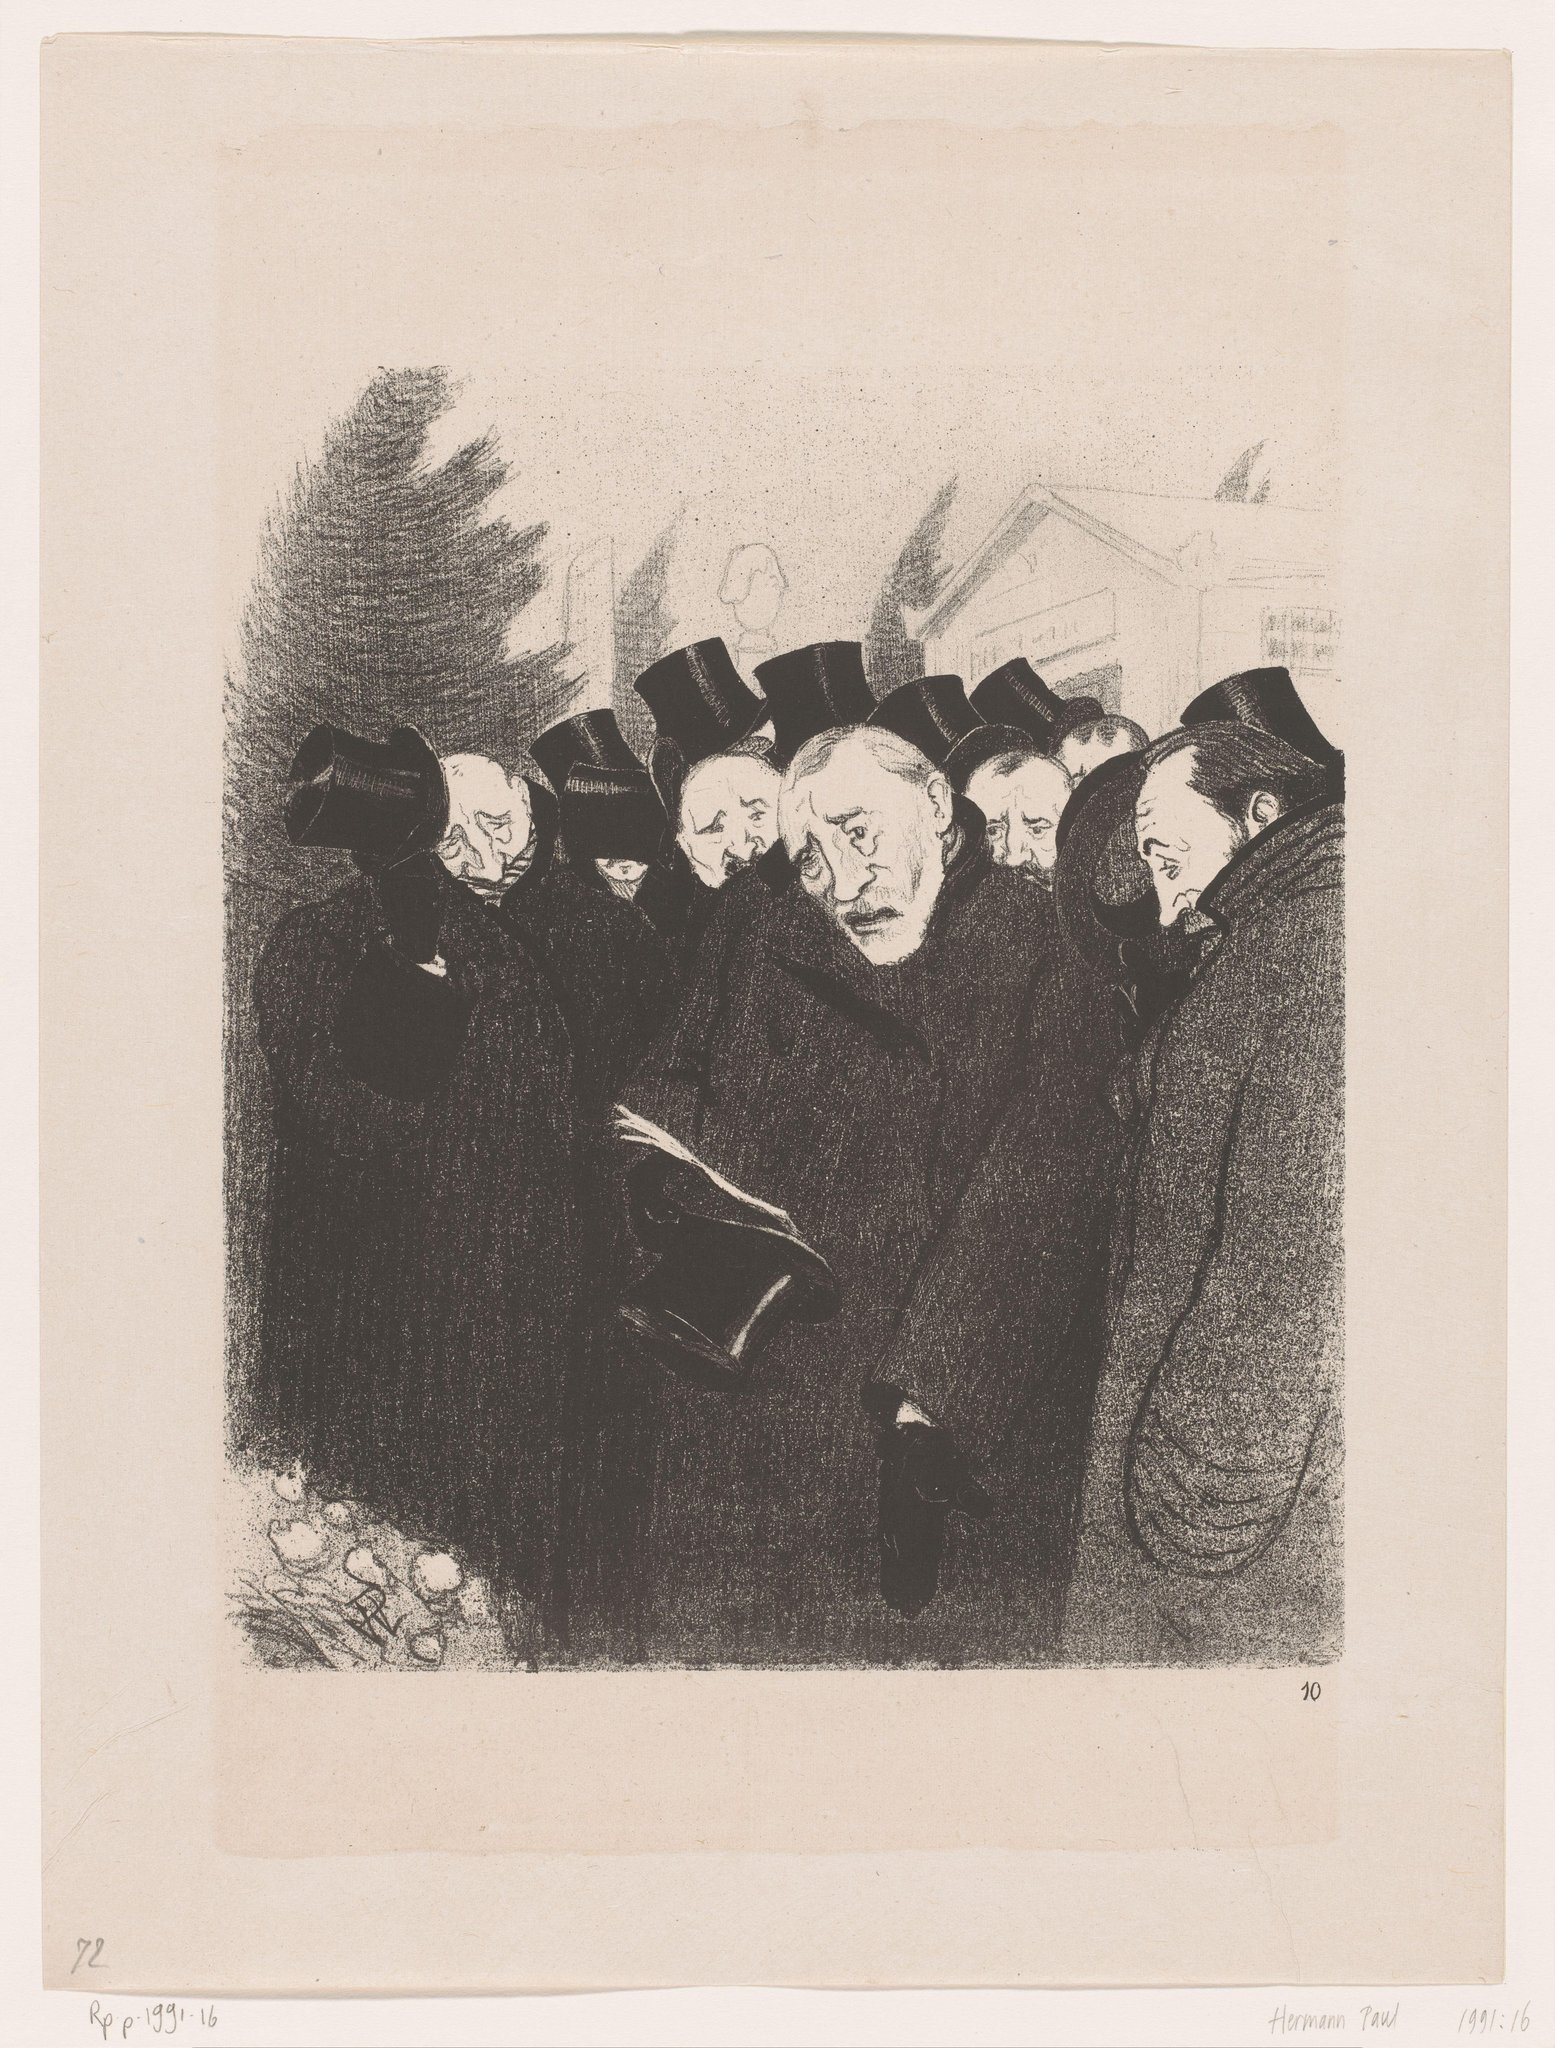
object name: print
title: Il est mort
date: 1895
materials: paper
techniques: lithograph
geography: paris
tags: burial